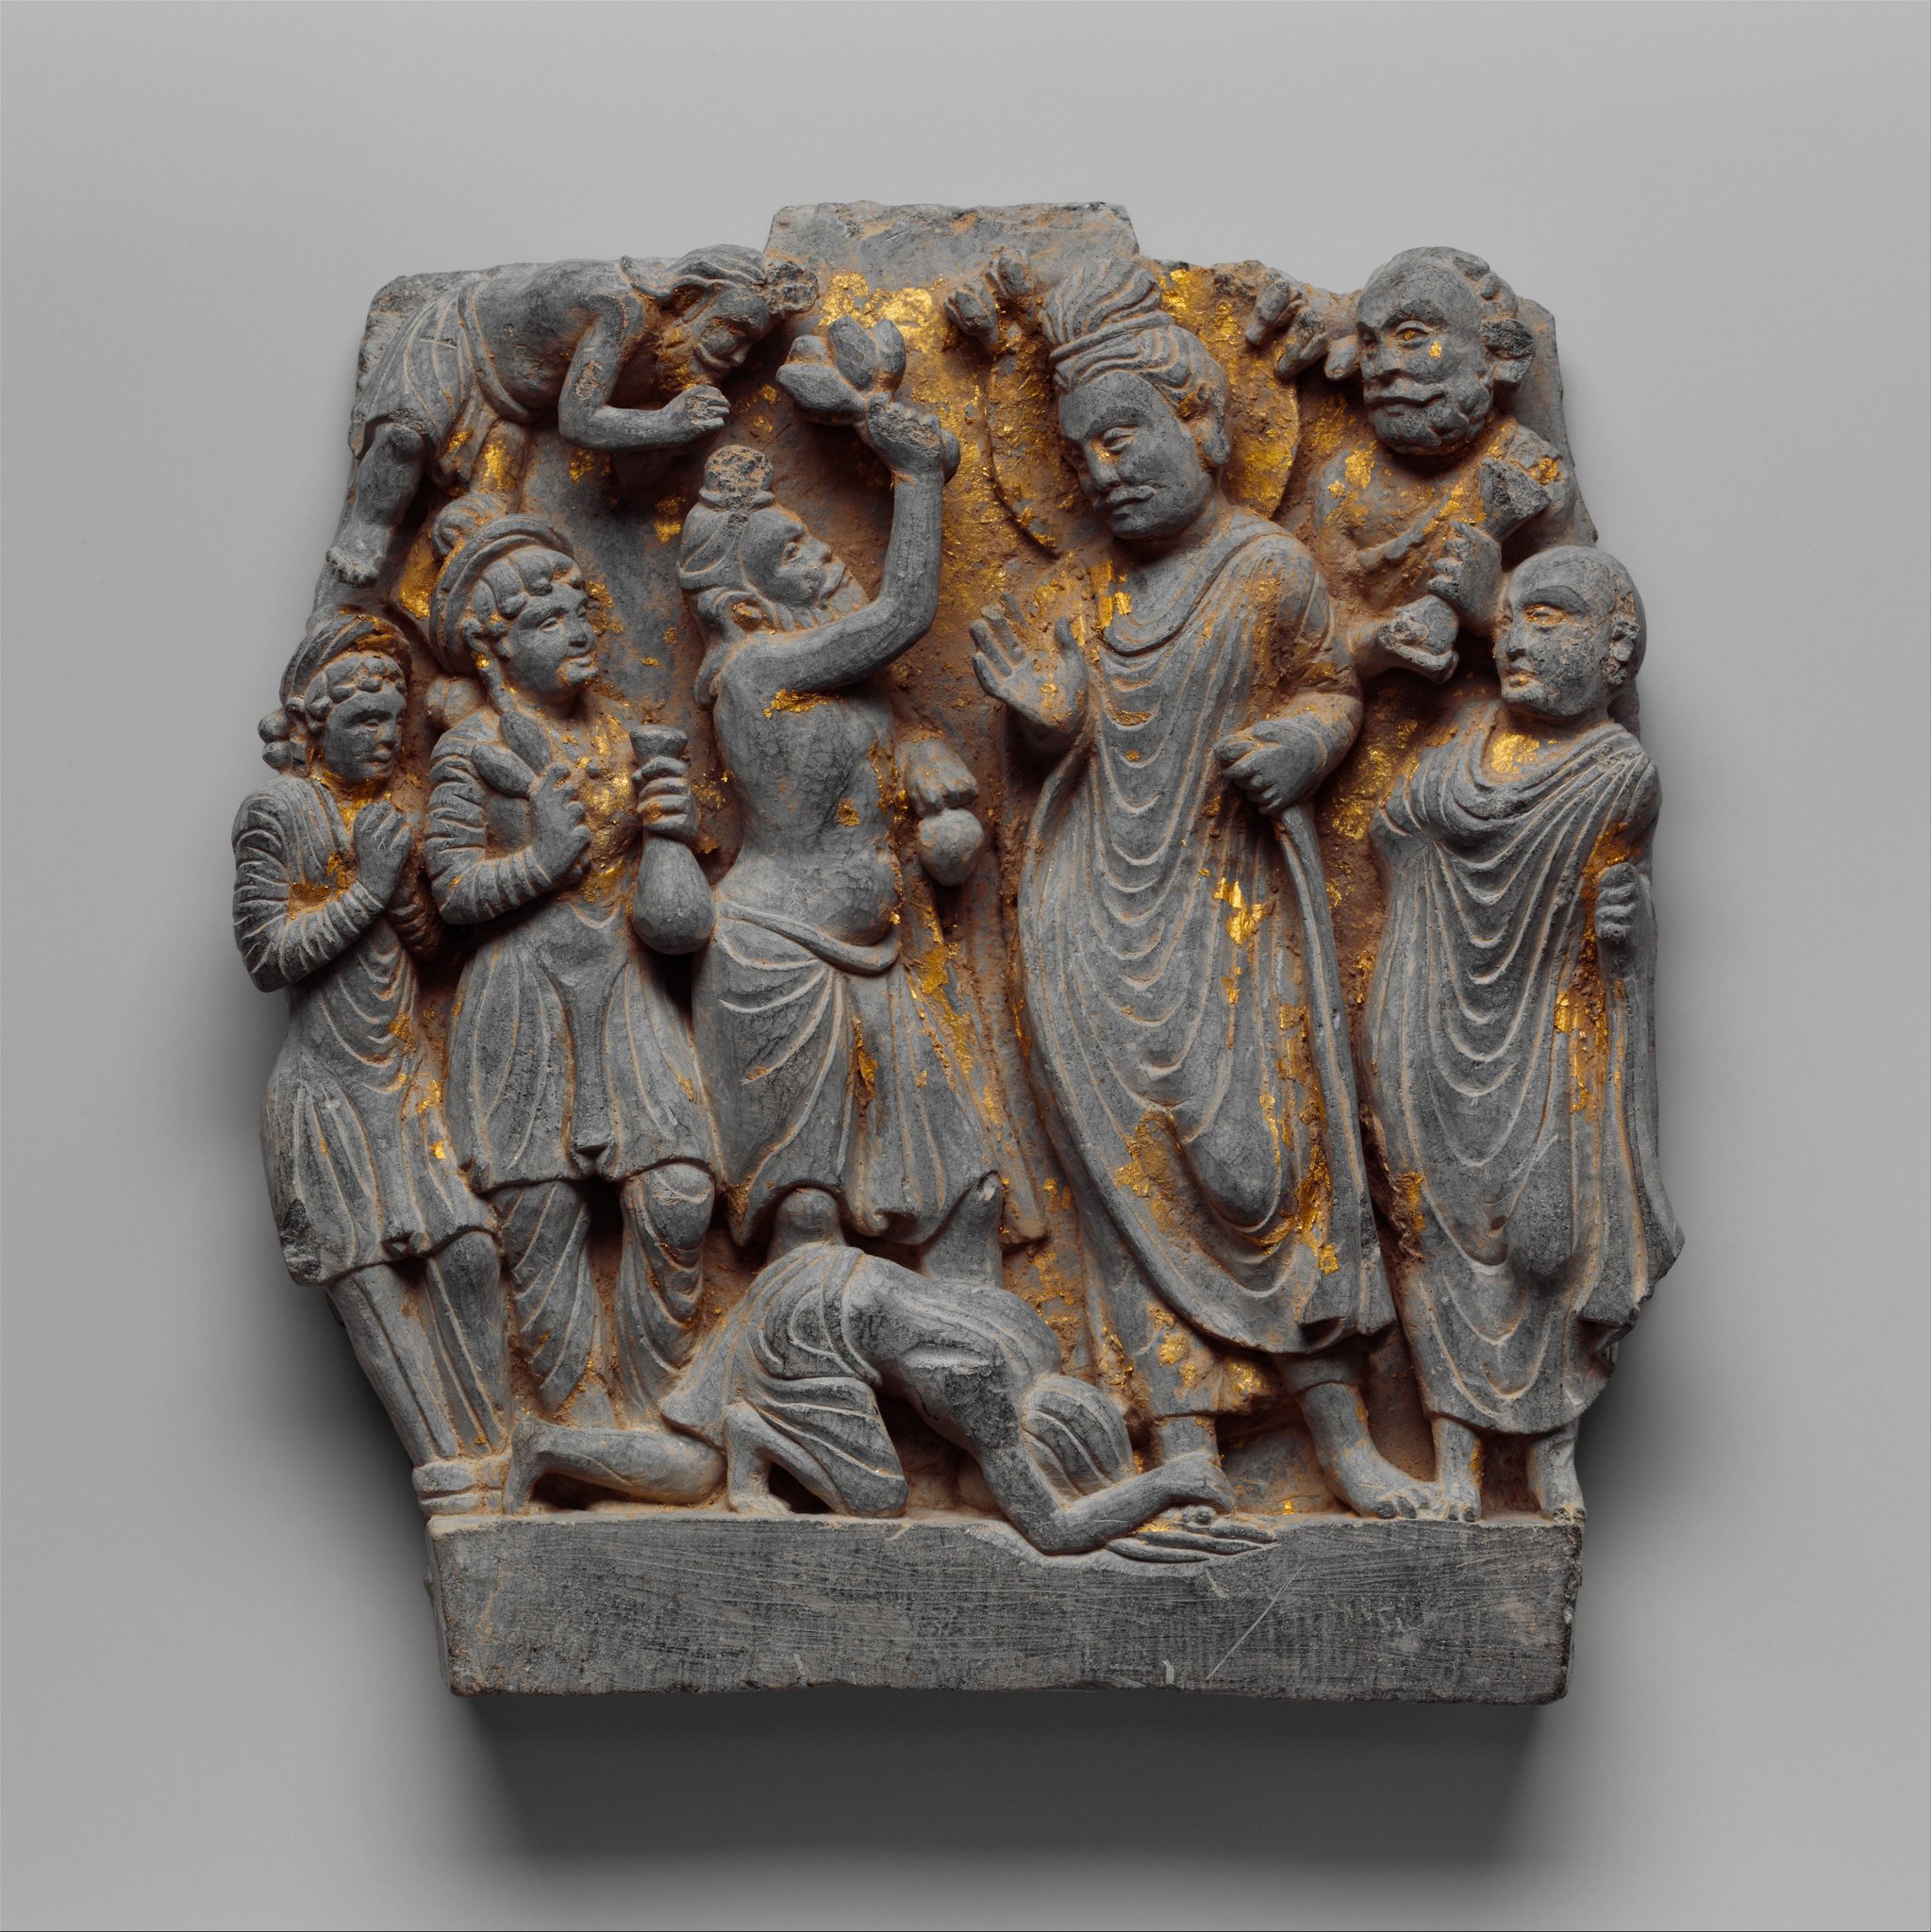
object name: relief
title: Dipankara Jataka (The Story of the Ascetic Megha and the Buddha Dipankara)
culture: pakistani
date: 101-200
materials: gold leaf, stone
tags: gandhara,men,buddha